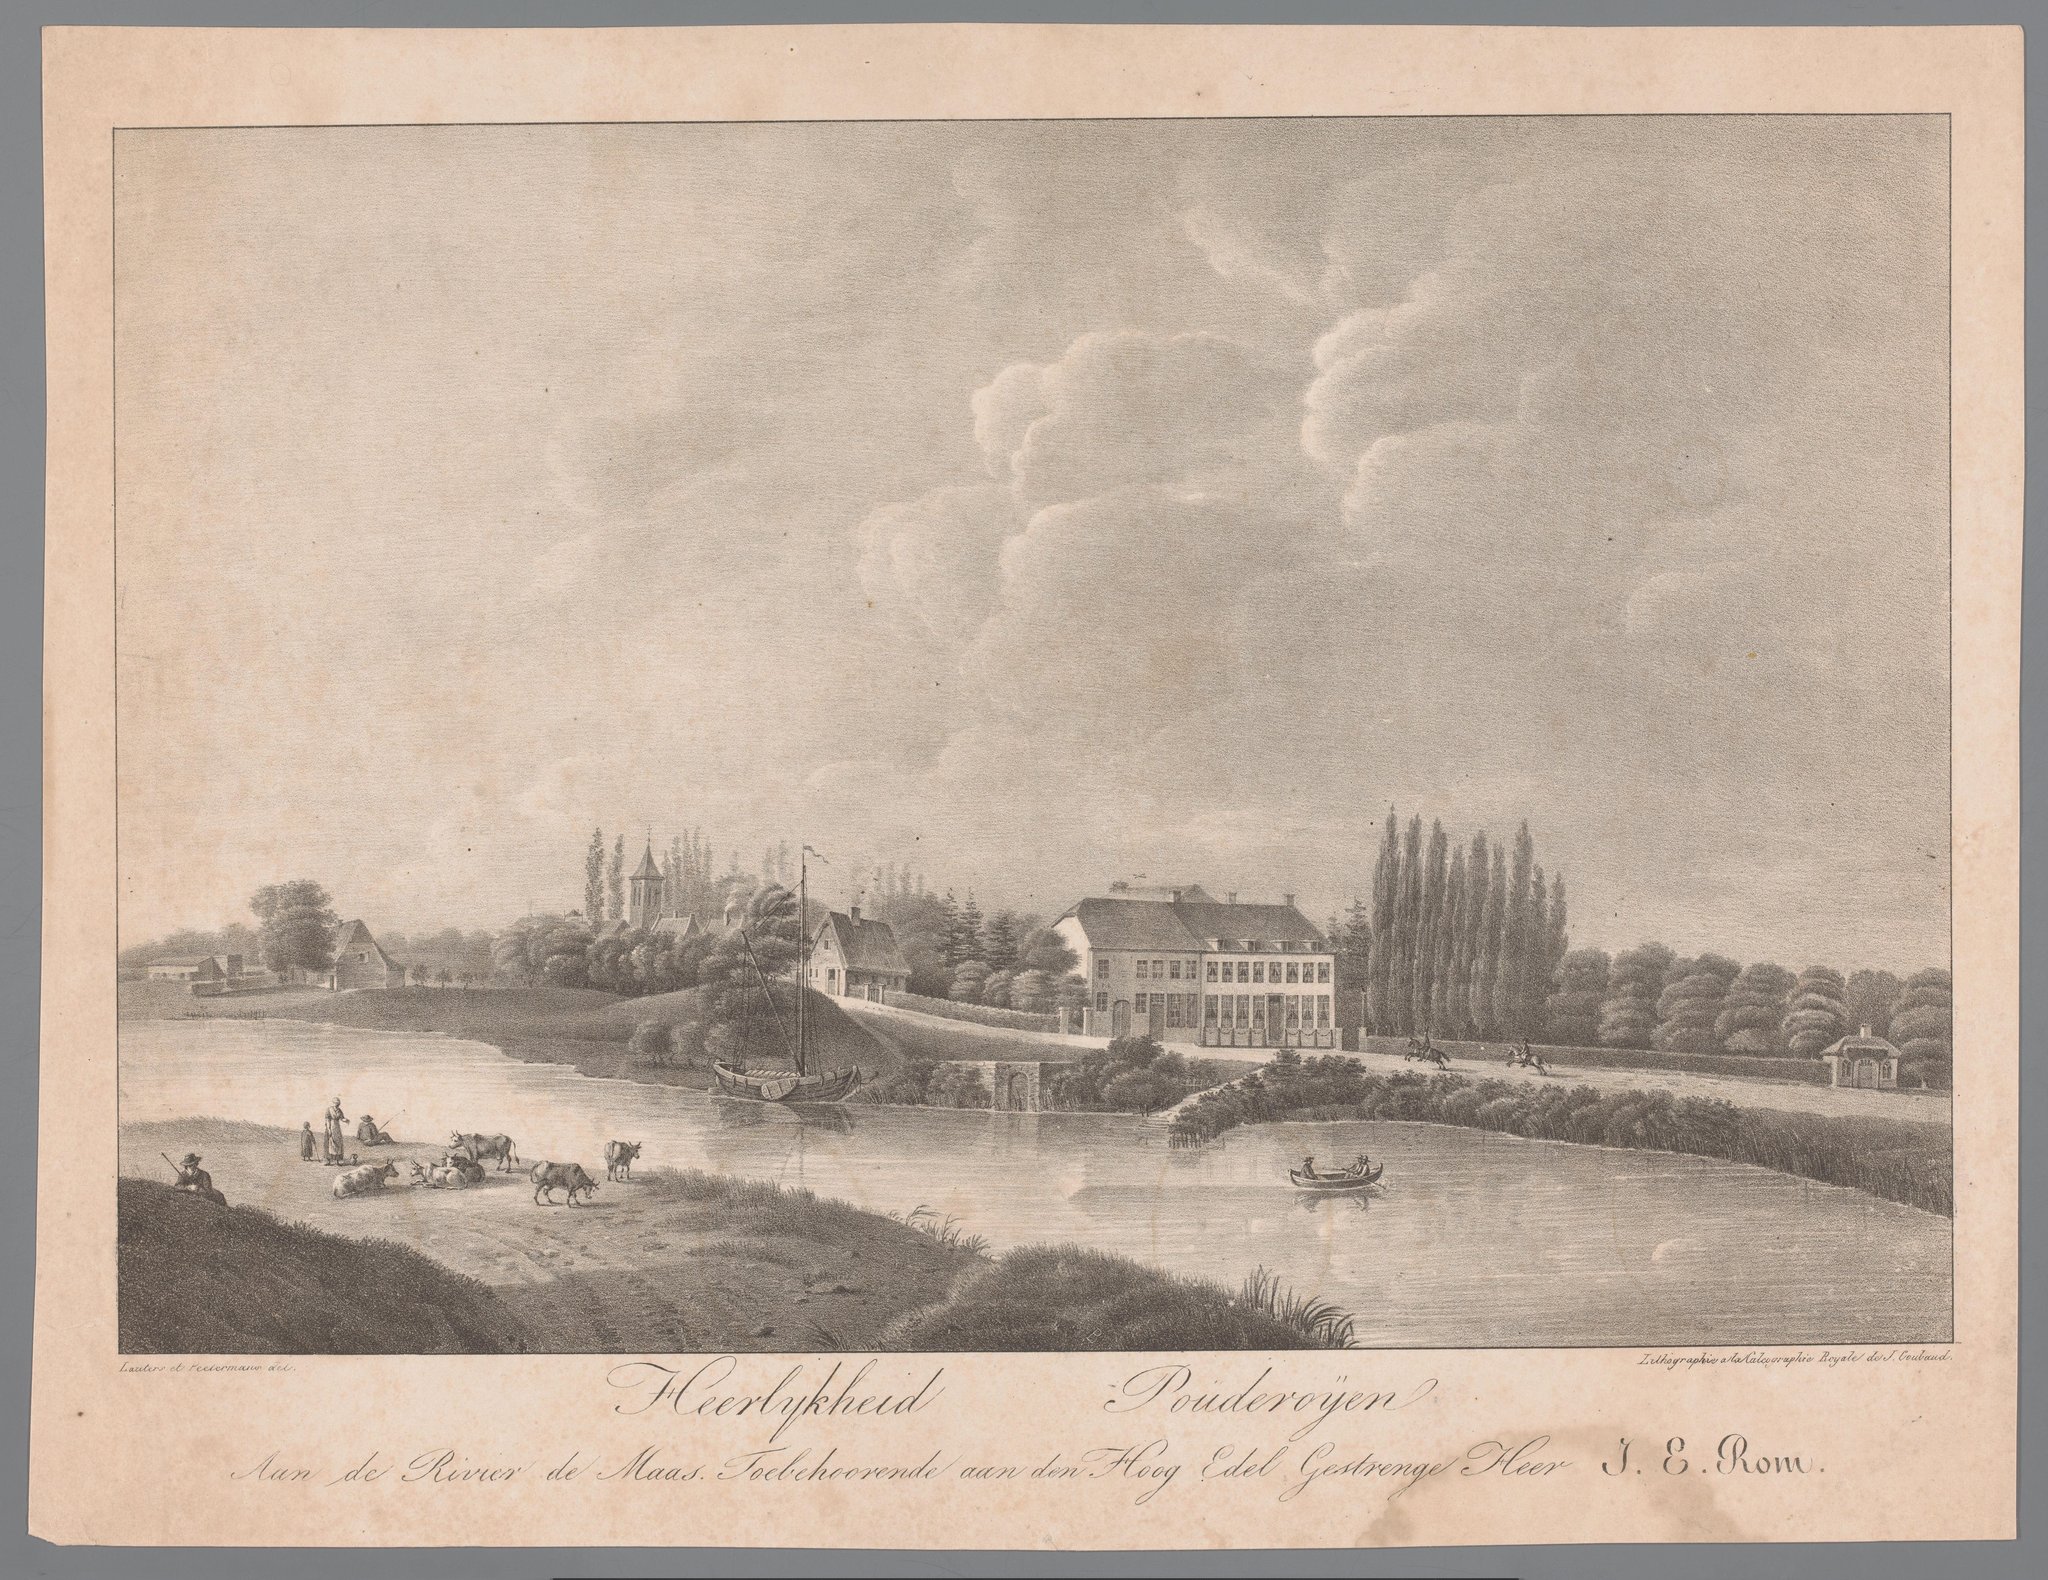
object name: print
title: Heerlijkheid Pouderoijen Aan de Rivier de Maas (...)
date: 1816-1847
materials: paper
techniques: lithograph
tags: river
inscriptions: collector's mark: Lugt 2228